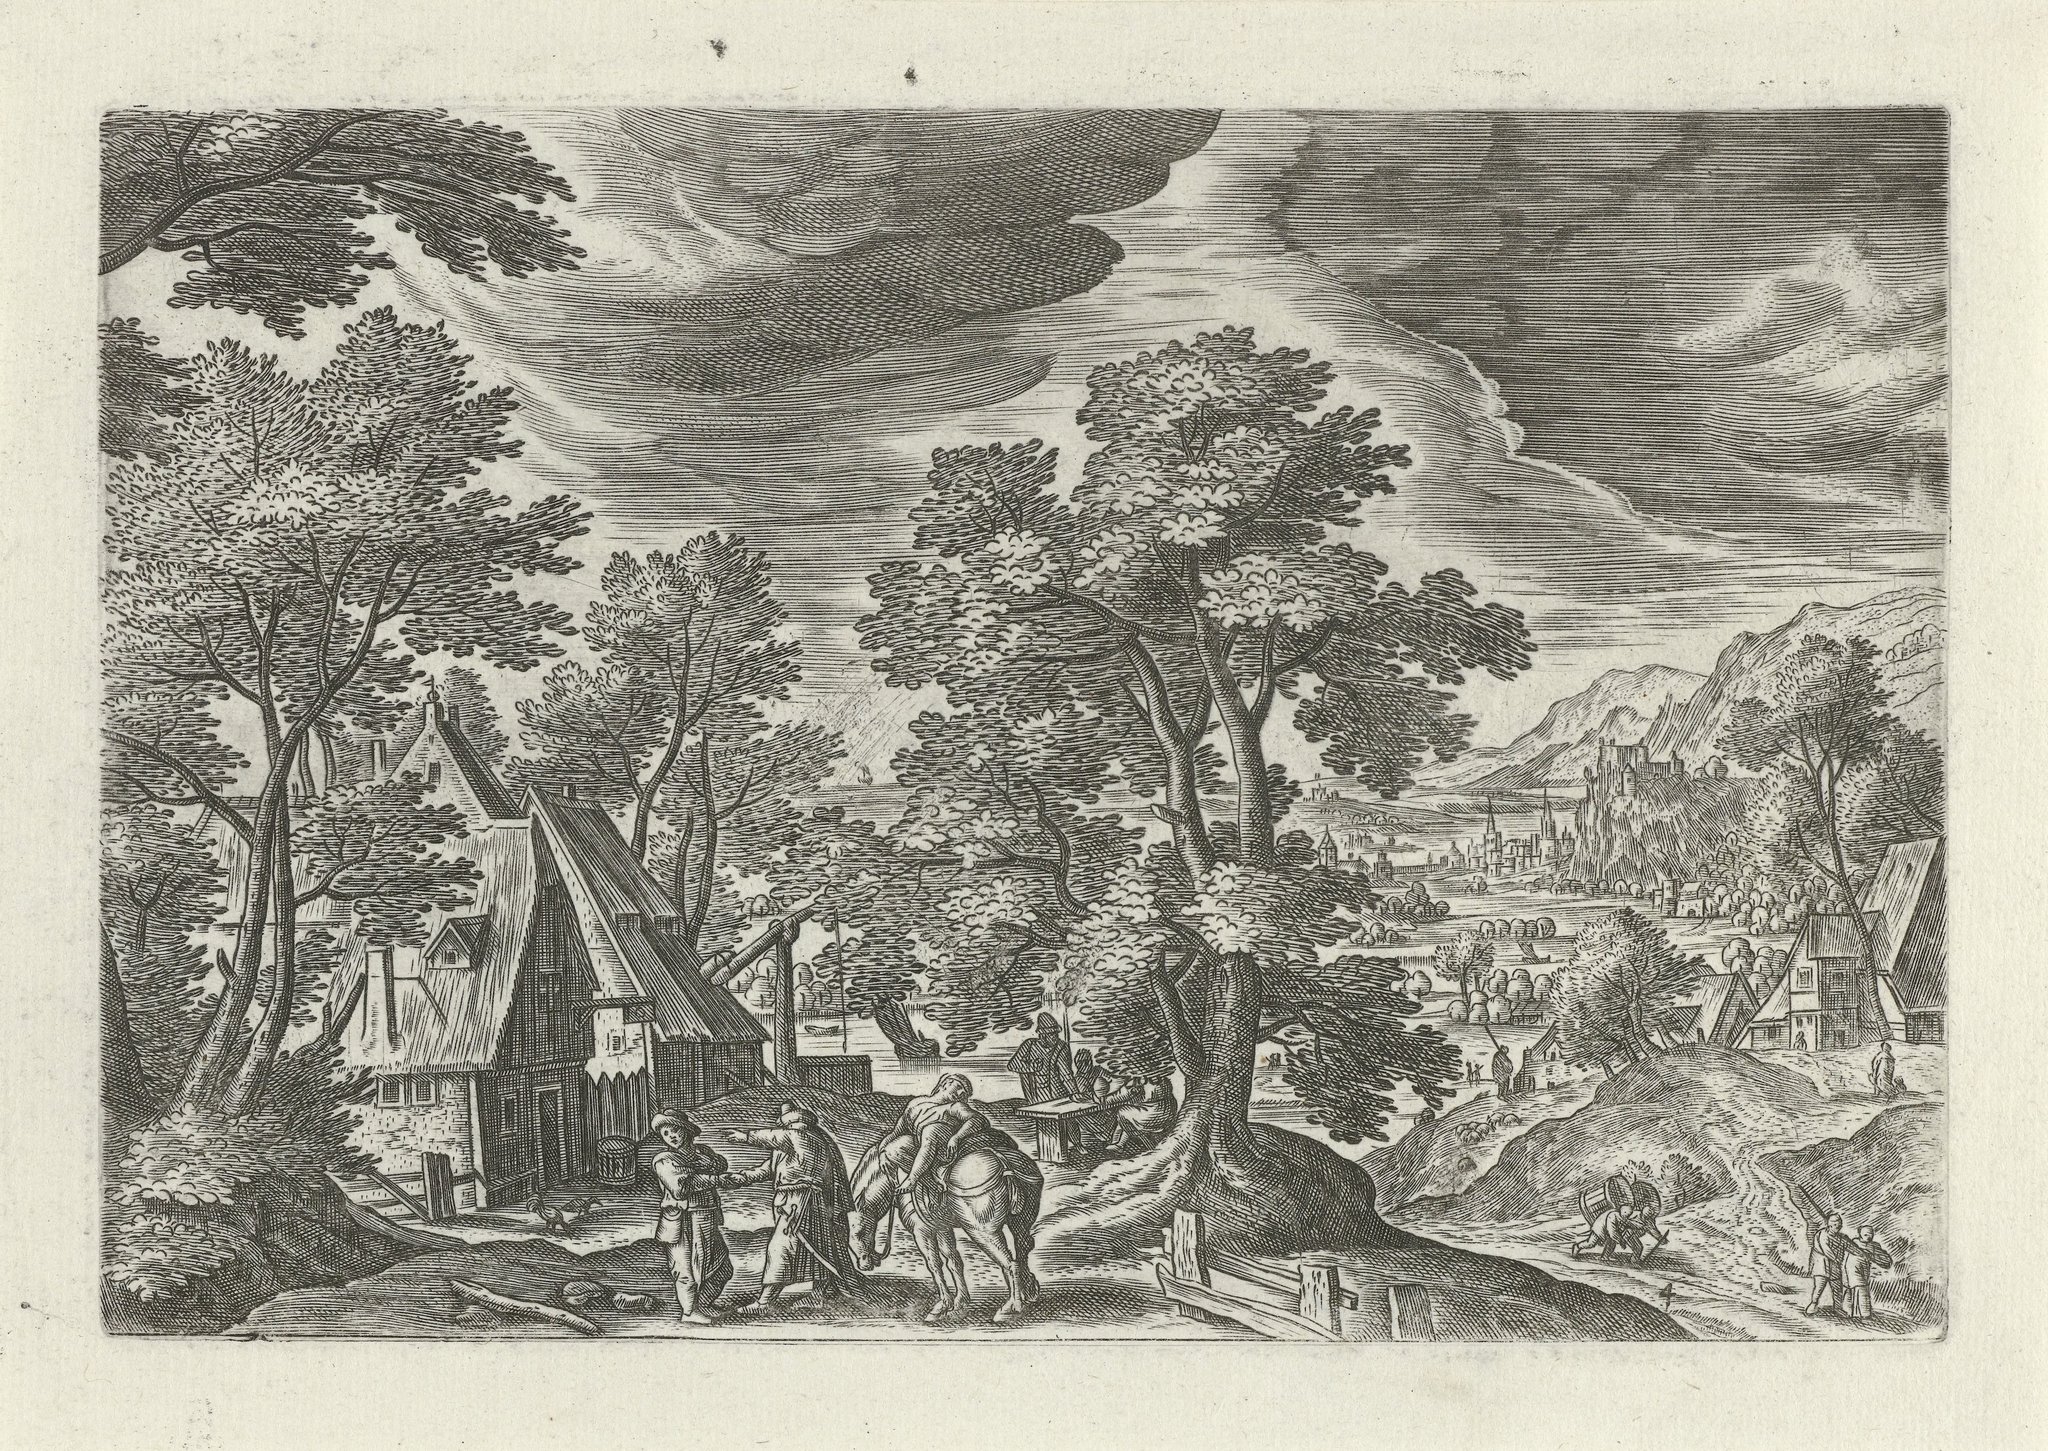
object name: print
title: Landschap met de barmhartige Samaritaan die de gewonde reiziger bij een herberg afzet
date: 1560-1595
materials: paper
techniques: engraving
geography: antwerp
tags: the samaritan pays the innkeeper, forest, wood (+ landscape with figures, staffage), outskirts of village (+ city(-scape) with figures, staffage)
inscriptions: collector's mark: Lugt 2228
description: Een herberg. De barmhartige Samaritaan betaalt een herbergier om de gewonde reiziger verder te verplegen. De prent is deel van een vierdelige serie van landschappen met scènes uit de gelijkenis van de barmhartige Samaritaan